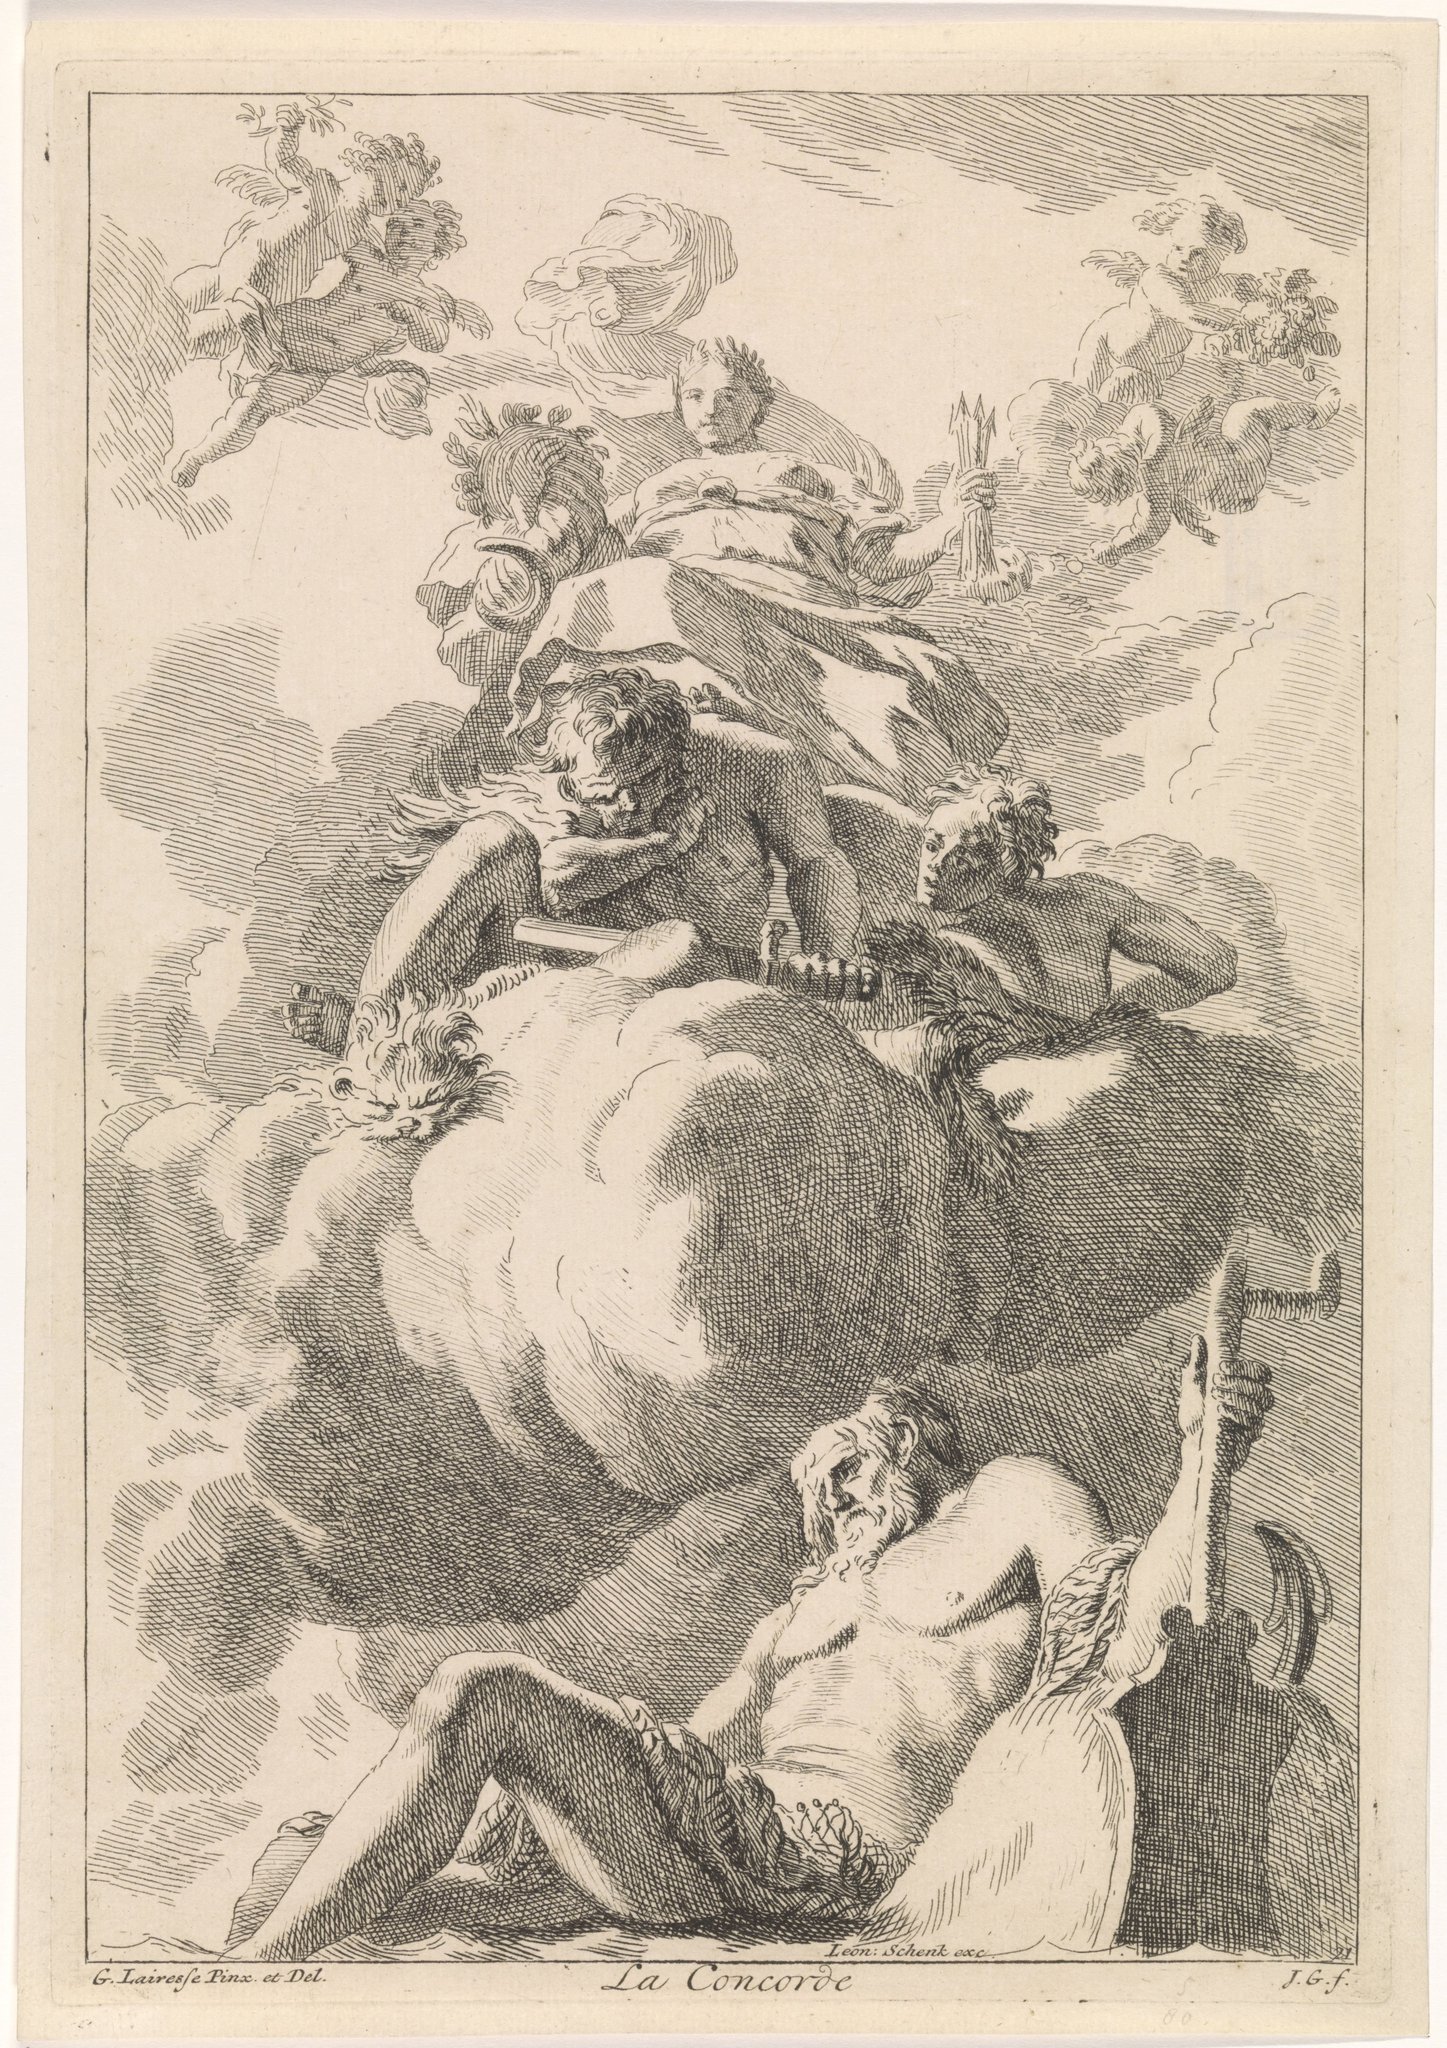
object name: print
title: La concorde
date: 1672-1726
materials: paper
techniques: etching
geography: amsterdam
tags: agreement, unity; 'concordia', 'concordia insuperabile', 'concordia militare', 'concordia di pace', 'unione civile' (ripa), river personified, 'fiumi' (ripa), anger; 'ira' (ripa) ~ personification of one of the seven deadly sins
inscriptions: collector's mark: Lugt 11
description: In de wolken Eendracht, met de cornucopia en met een bos pijlen in haar hand. Rondom haar putti. Ze heeft de personificatie Toorn geketend. Op de voorgrond de personificatie van de rivier Ij. De prent is naar een plafondschilderij van Gerard de Lairesse en maakt deel uit van een serie met Bijbelse, mythologische en allegorische voorstellingen.